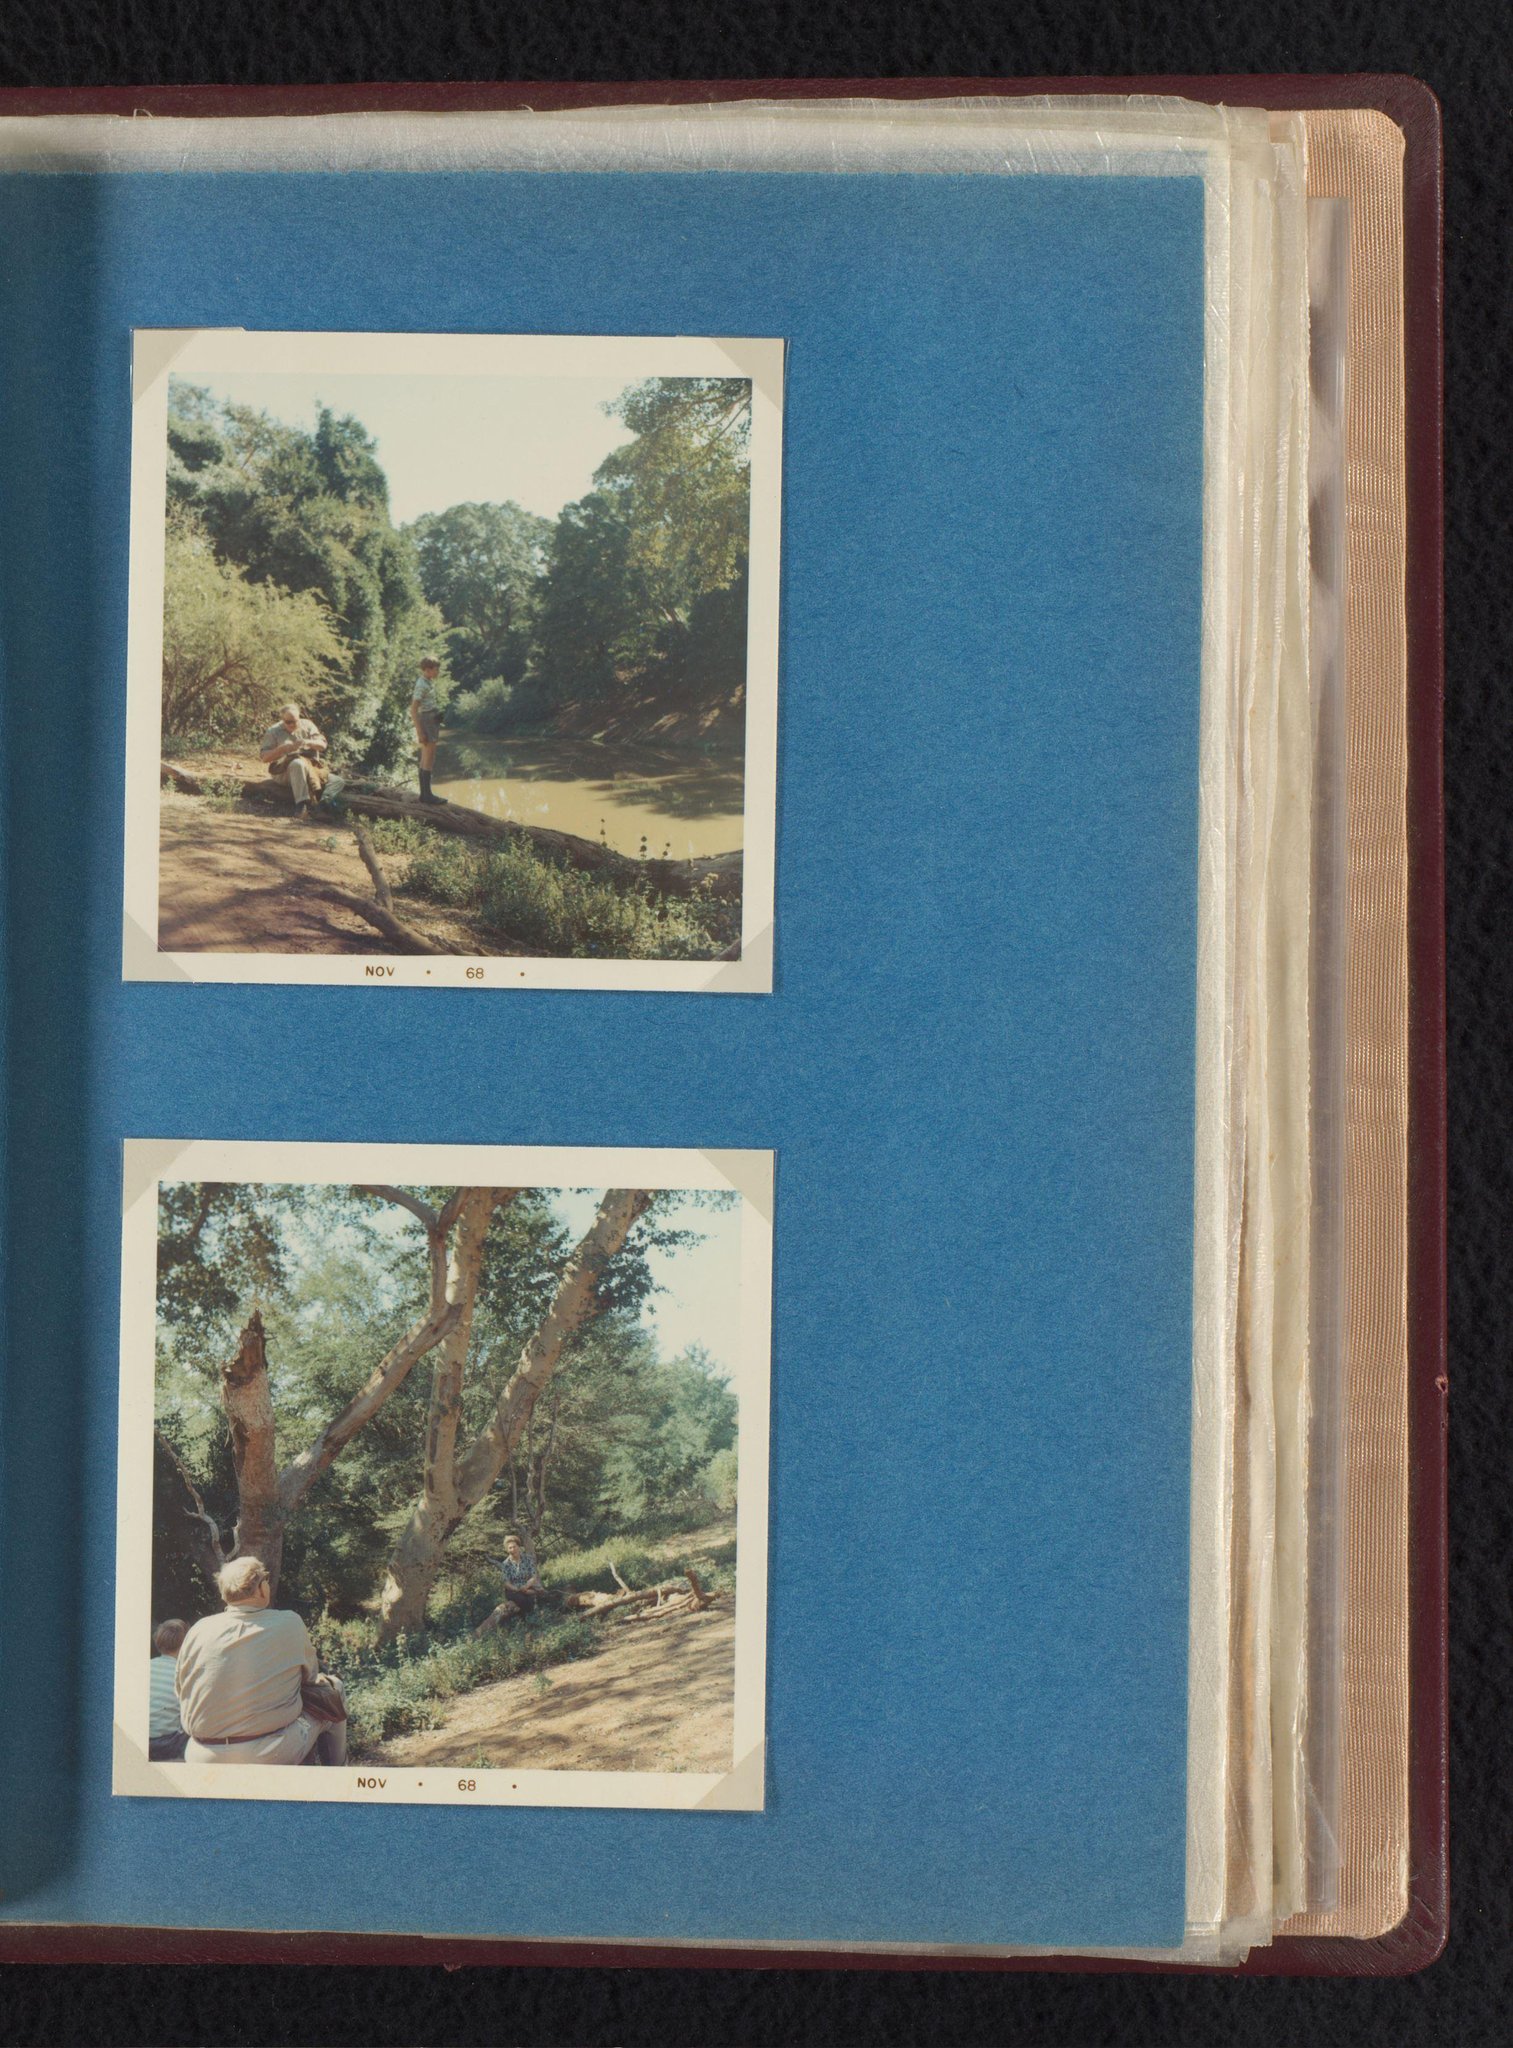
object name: album leaf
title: Willem van den Berg met een vrouw en een jongen bij een rivier in Makuleke, Zuid-Afrika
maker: willem jacob van den berg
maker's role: boer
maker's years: 1902-1983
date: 1911-1968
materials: paper, cardboard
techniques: chromogenic print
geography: makuleke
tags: willem jacob van den berg, river, forest, wood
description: Deze foto's zijn onderdeel van een album.